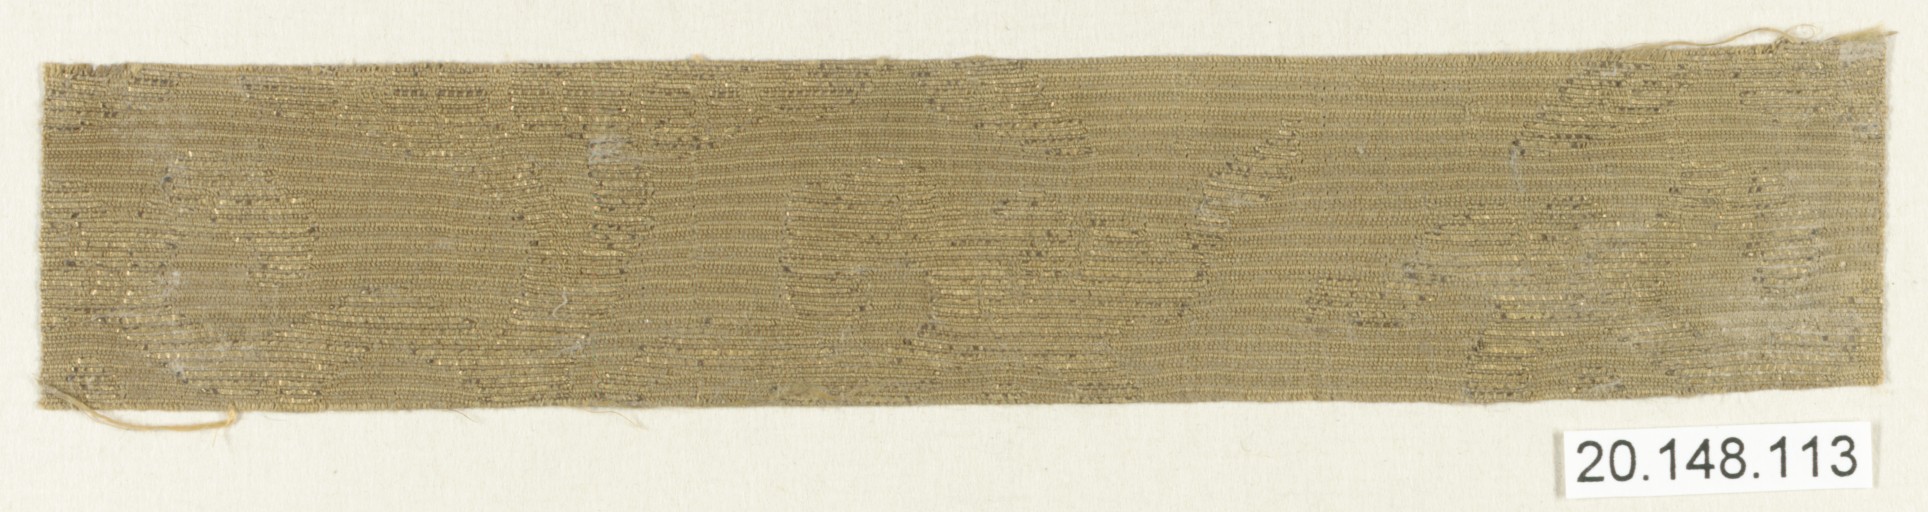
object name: piece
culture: japanese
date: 1701-1800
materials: silk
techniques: compound weave